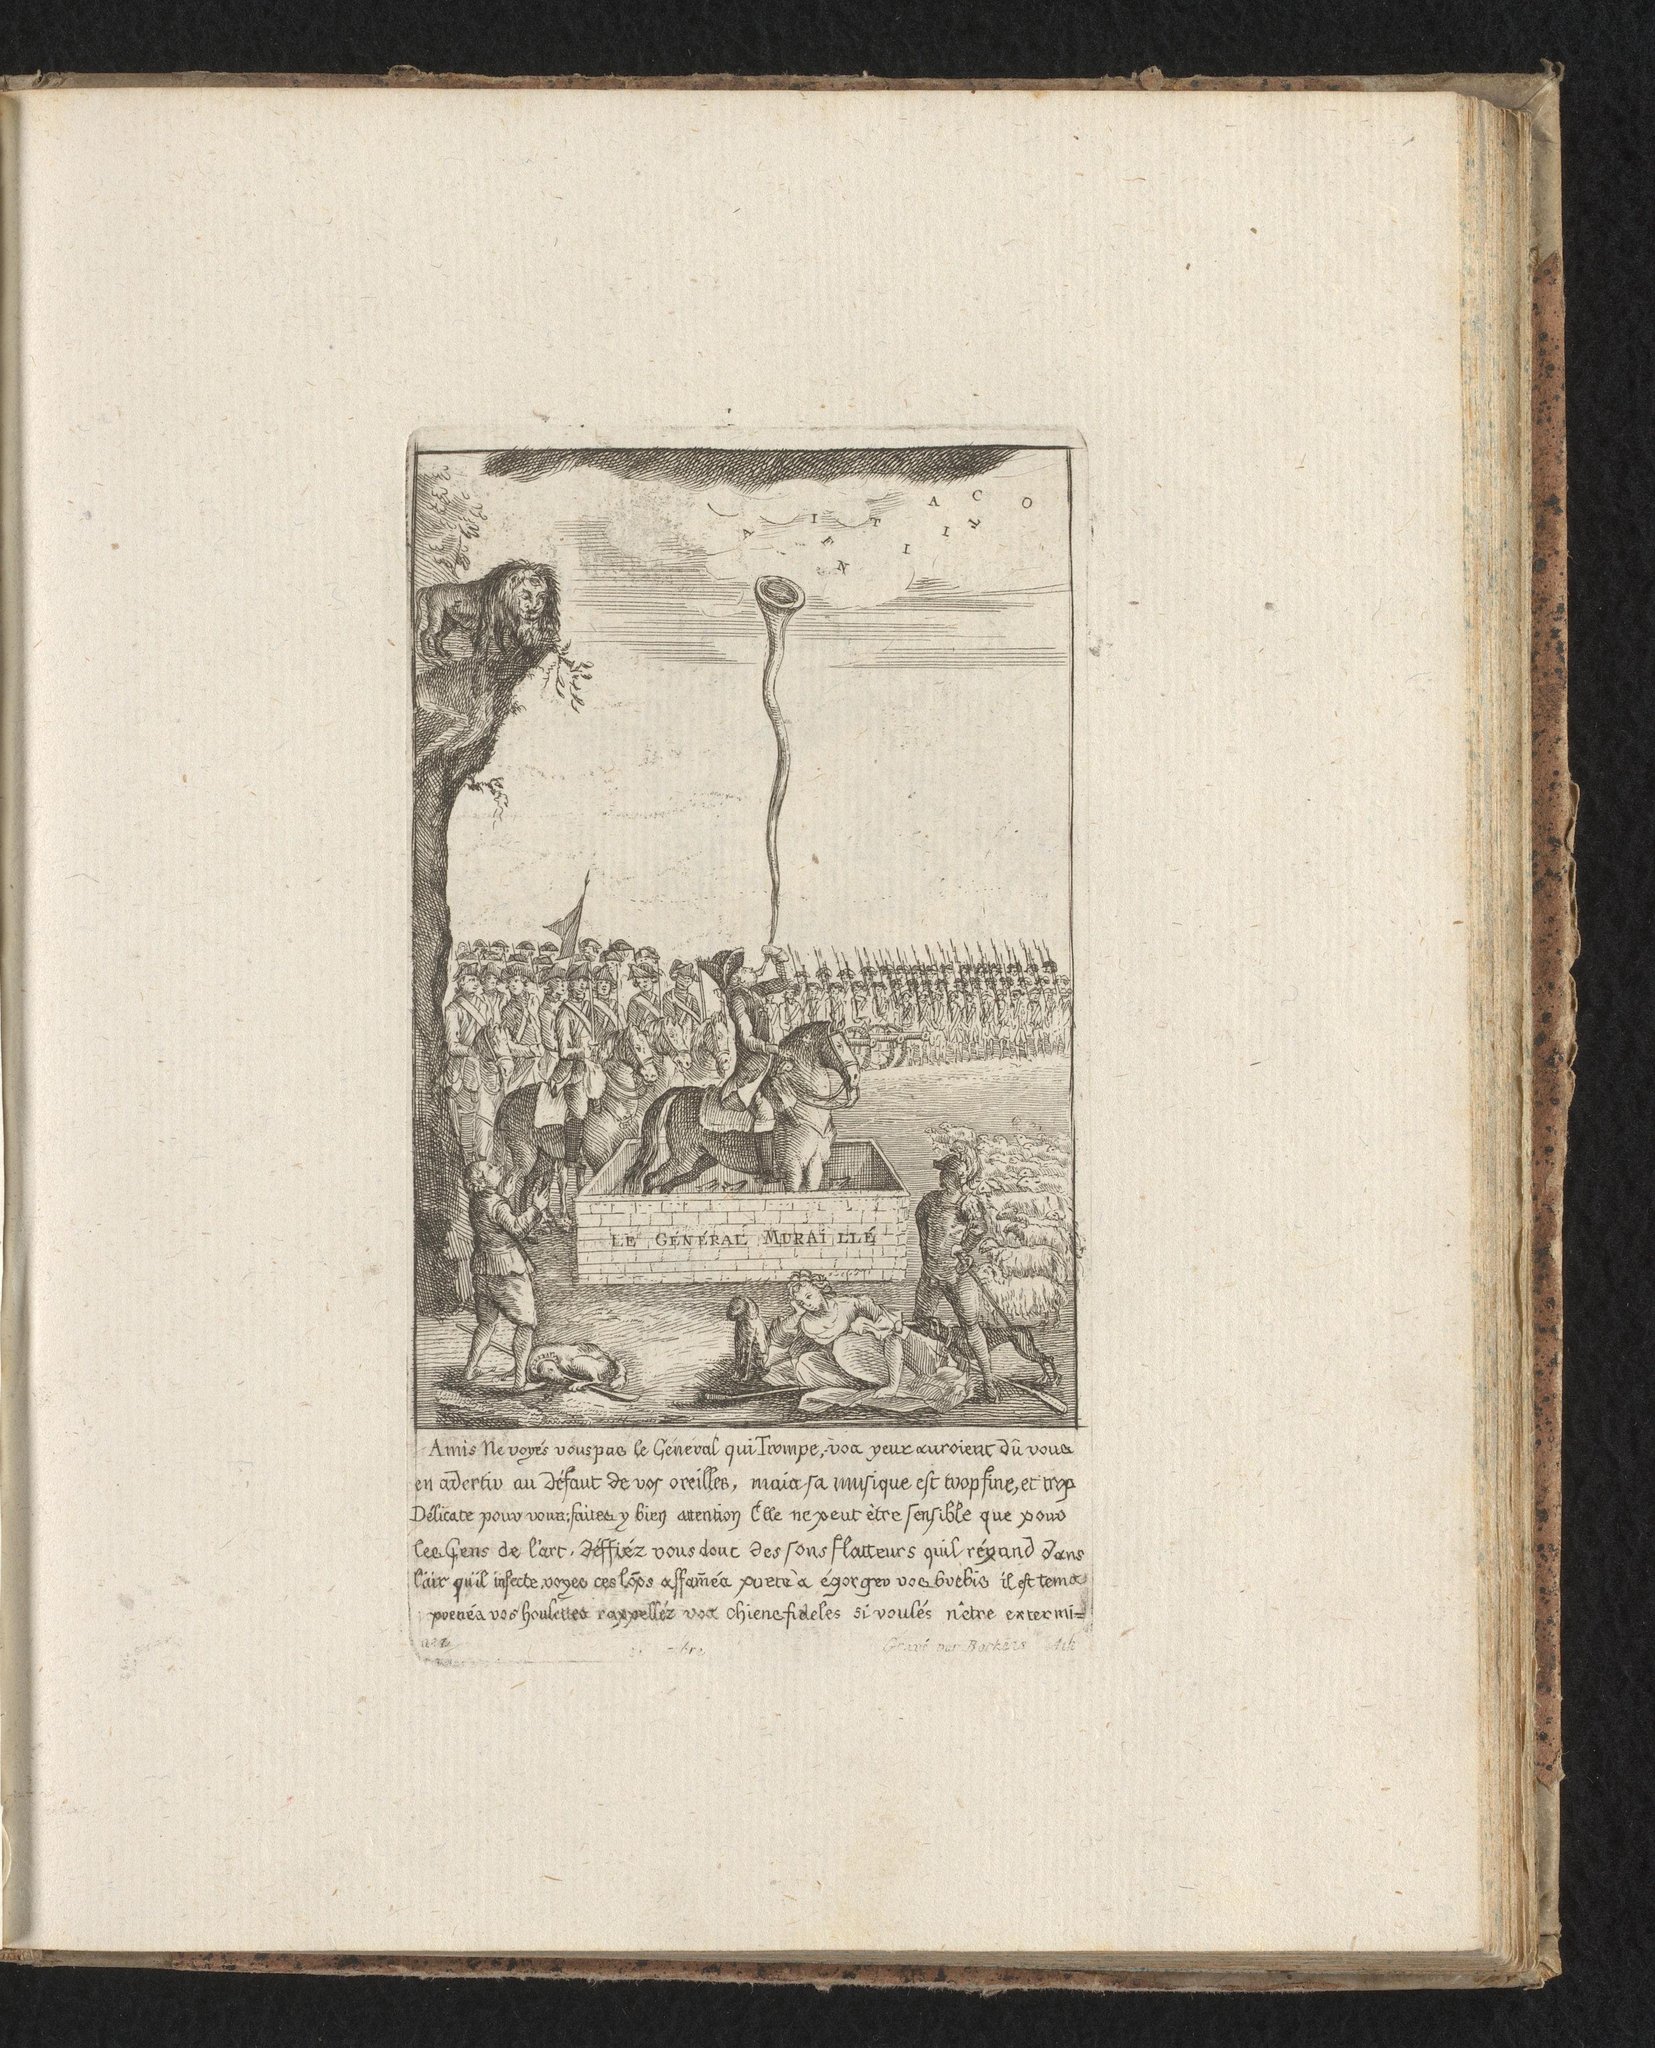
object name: cartoon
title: De ommuurde generaal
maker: borkens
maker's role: print maker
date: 1787-1790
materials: paper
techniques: engraving, etching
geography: ath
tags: blowing the hunting horn, brabant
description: Spotprent met een generaal te paard binnen vier bakstenen muren. Hij blaast op een hele lange hoorn letters in de lucht. Manschappen te paard kijken toe. Met onderschrift van 6 regels in het Frans. Onderdeel van de gebundelde verzameling prenten betrekking hebbend op de gebeurtenissen van de Brabantse Omwenteling en de periode 1787-1790.